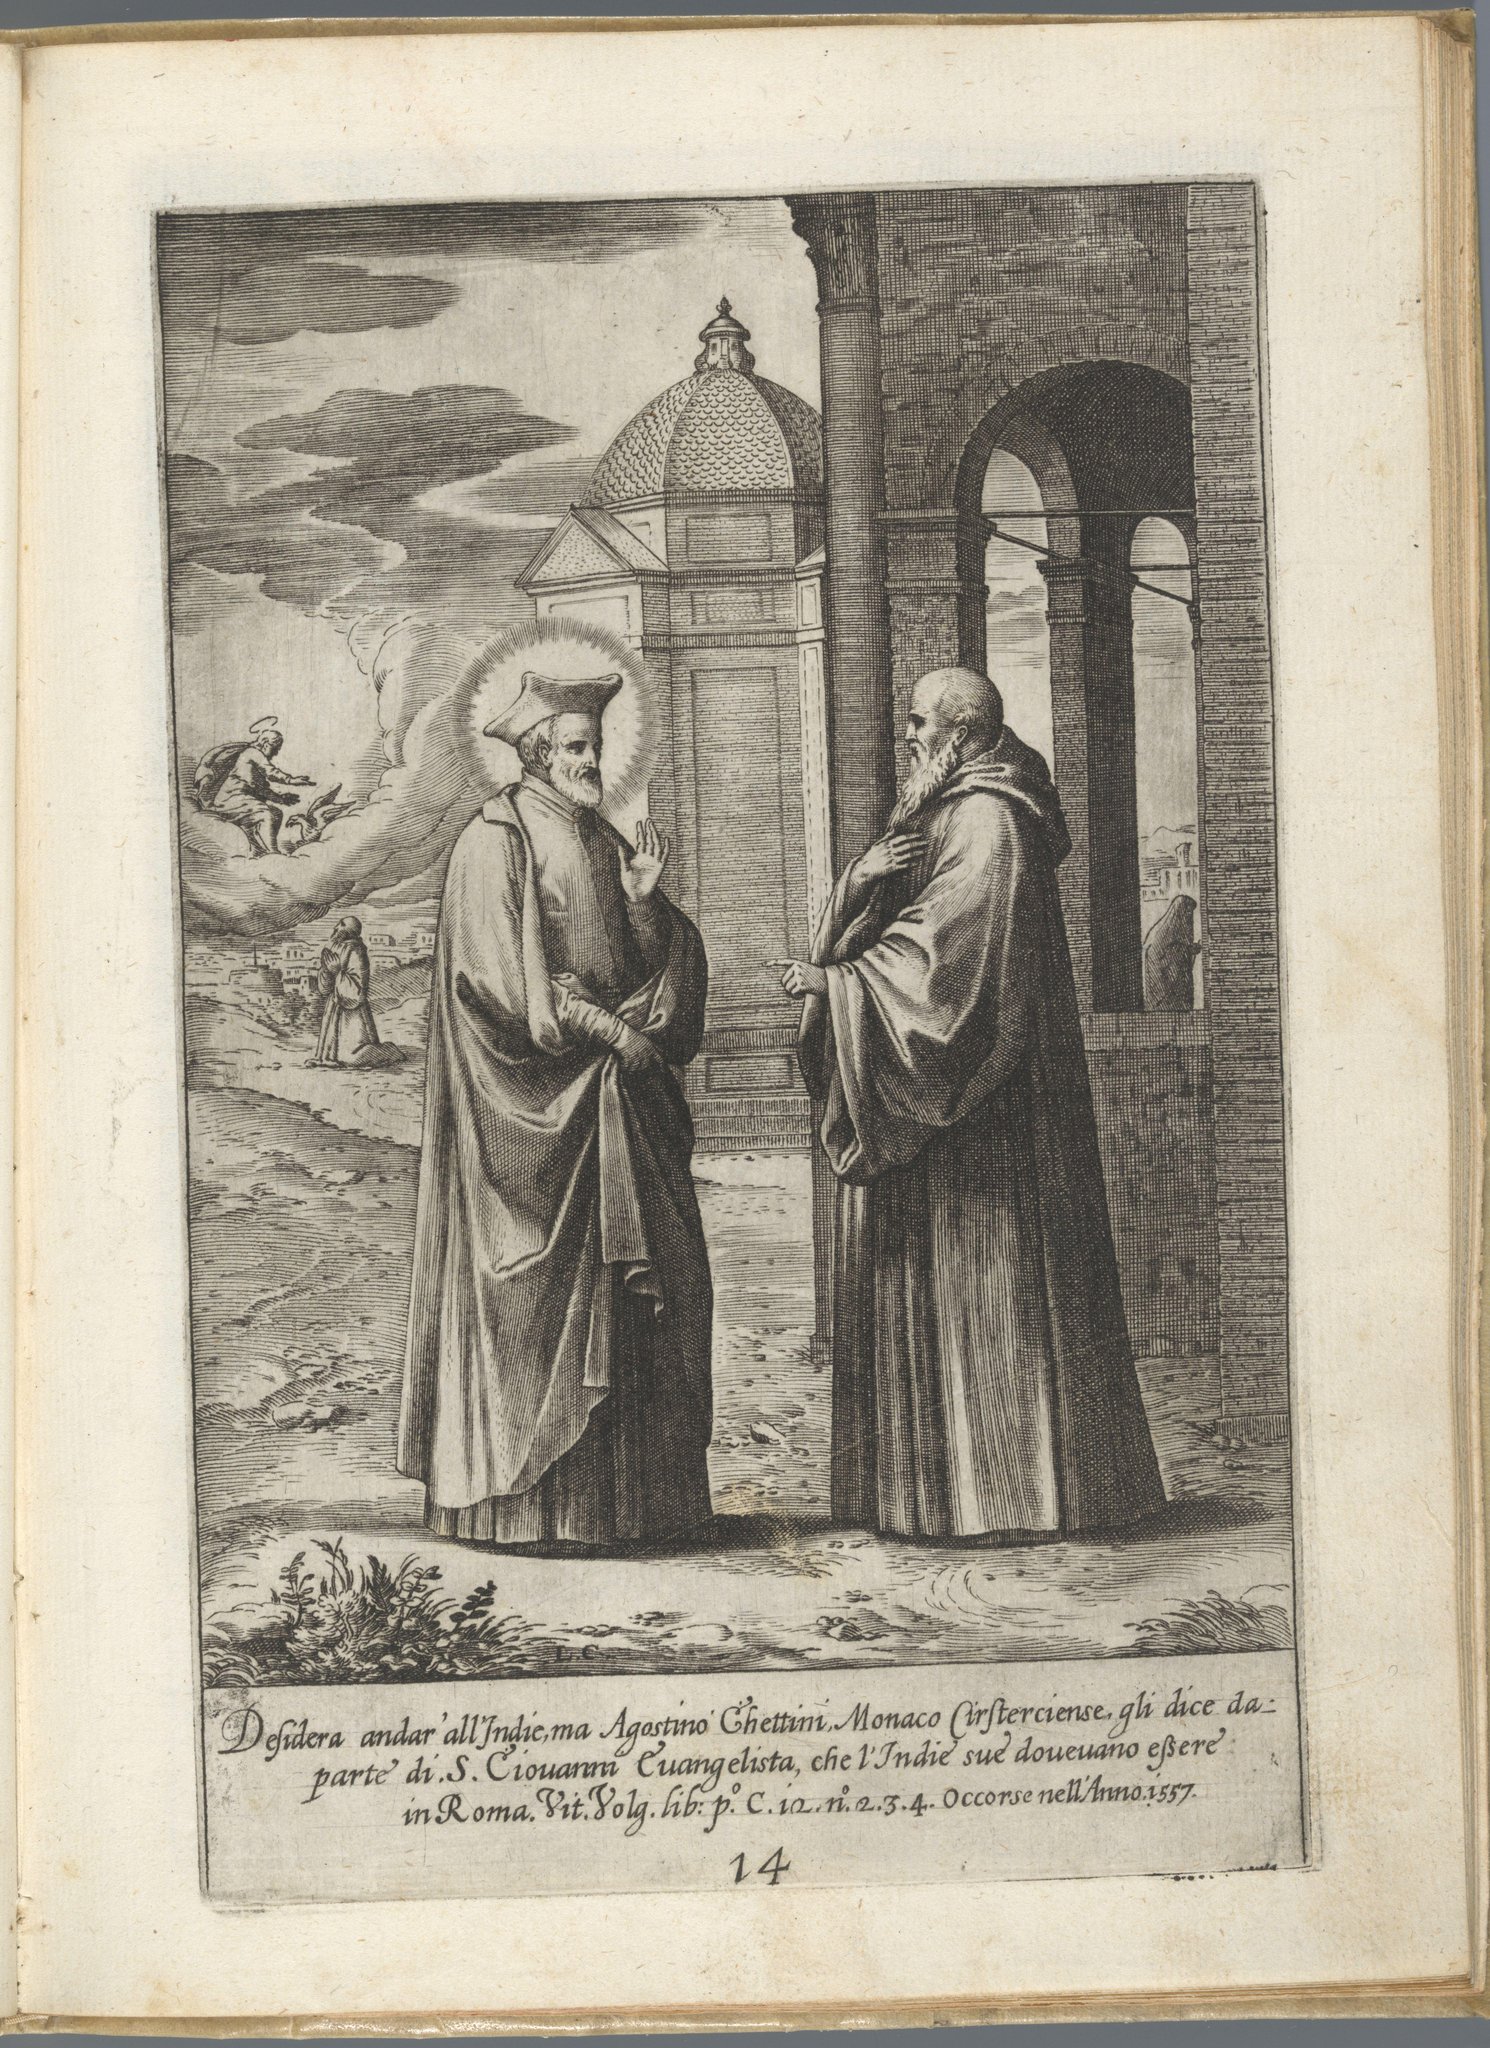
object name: print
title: Filippo Neri moet in Rome blijven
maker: luca ciamberlano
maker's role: painter, print maker, publisher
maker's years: 1570-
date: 1630-1641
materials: paper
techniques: engraving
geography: rome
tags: the founder of the congregation of the oratory (oratorians) philip neri; possible attributes: lily, rosary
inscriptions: collector's mark: Lugt 2228, collector's mark: Lugt 2760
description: Filippo Neri krijgt de boodschap door van Johannes de Doper dat hij niet naar India moet gaan maar in Rome moet blijven. Prent nr. 14 in een serie van 44 prenten met scènes uit het leven van de heilige Filippo Neri.